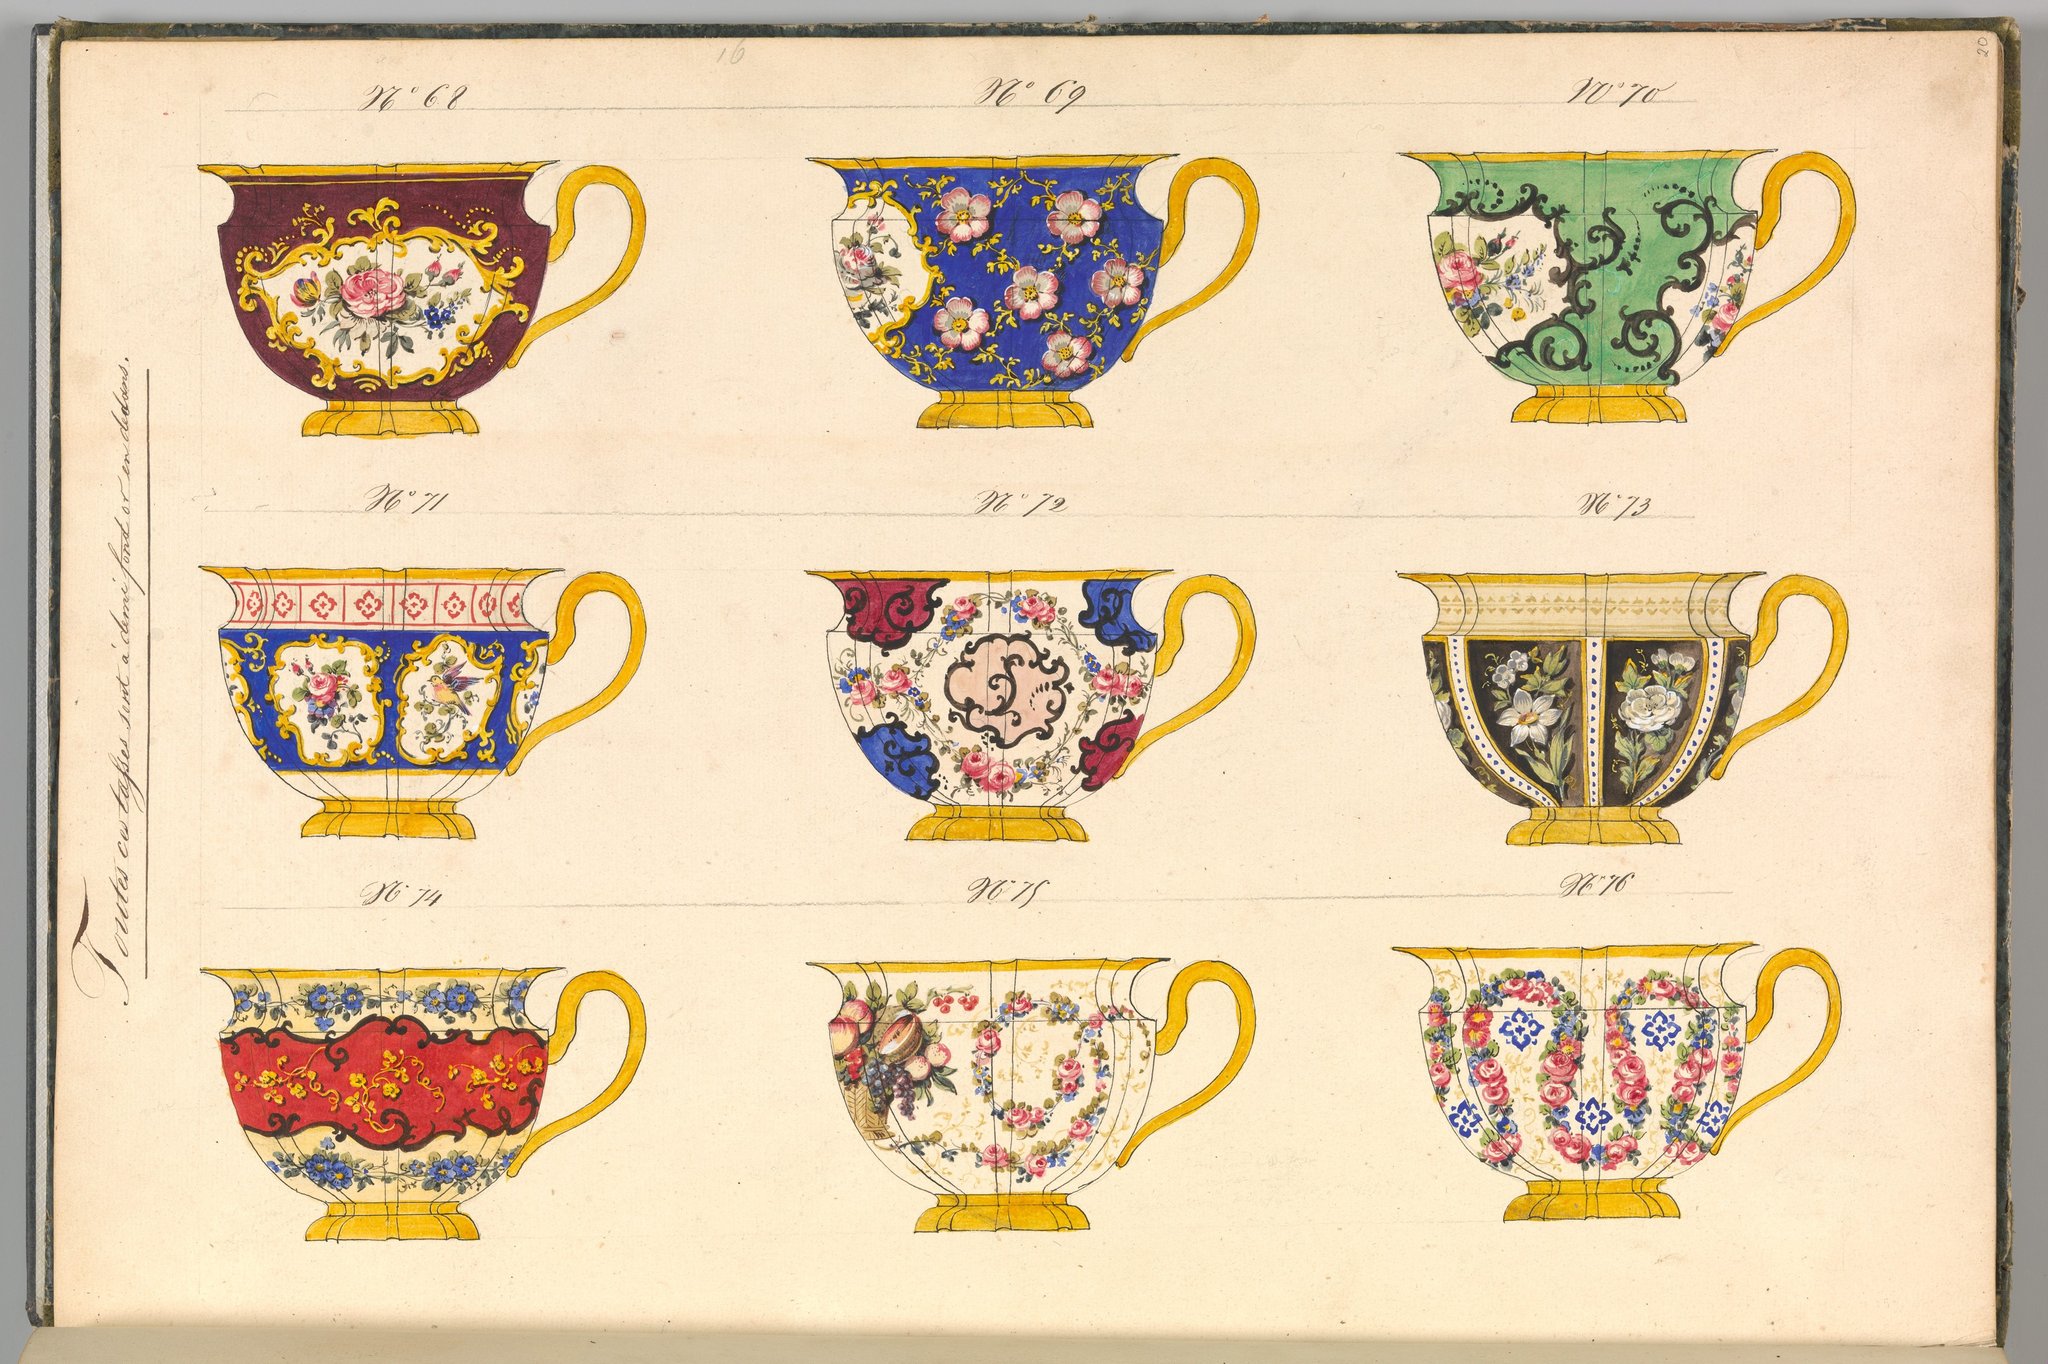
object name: album drawing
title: Porcelain Designs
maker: anonymous, french, 19th century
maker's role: artist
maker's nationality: french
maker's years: 1800-1900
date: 1825-1850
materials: ink, watercolor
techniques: pen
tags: flowers,cups